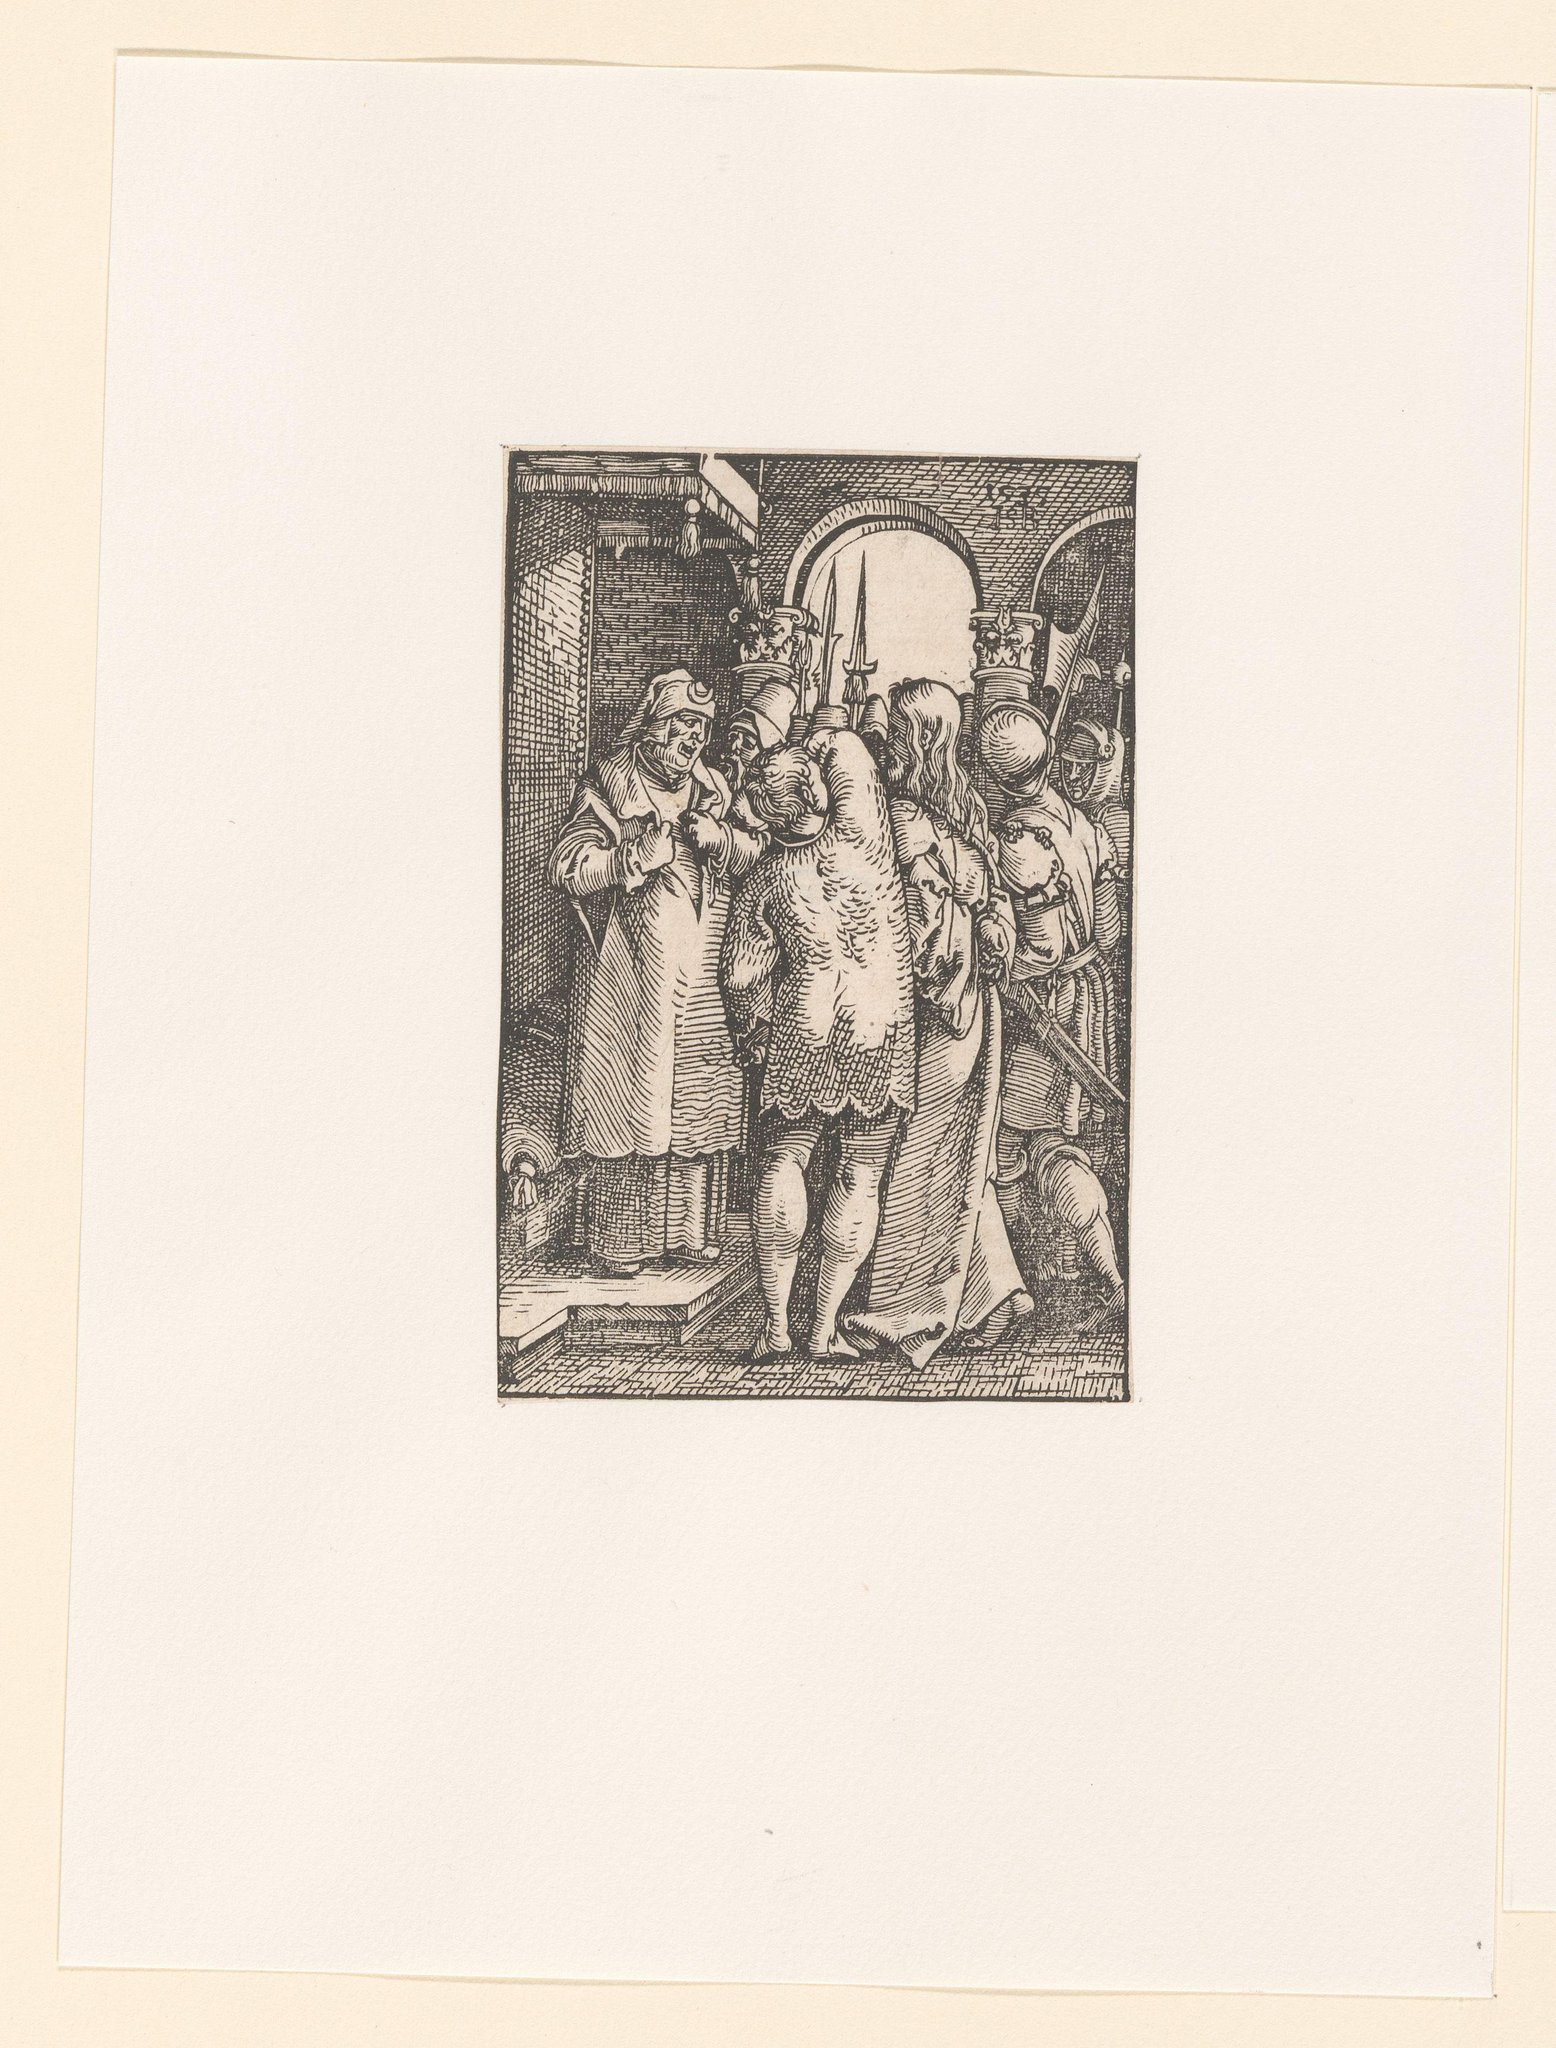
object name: print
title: Passie van Christus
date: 1535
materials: paper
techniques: woodcut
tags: caiaphas tearing his clothes ~ trial of christ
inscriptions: collector's mark: Lugt 2228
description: Onderdeel van een serie van acht prenten met de passie van Christus.